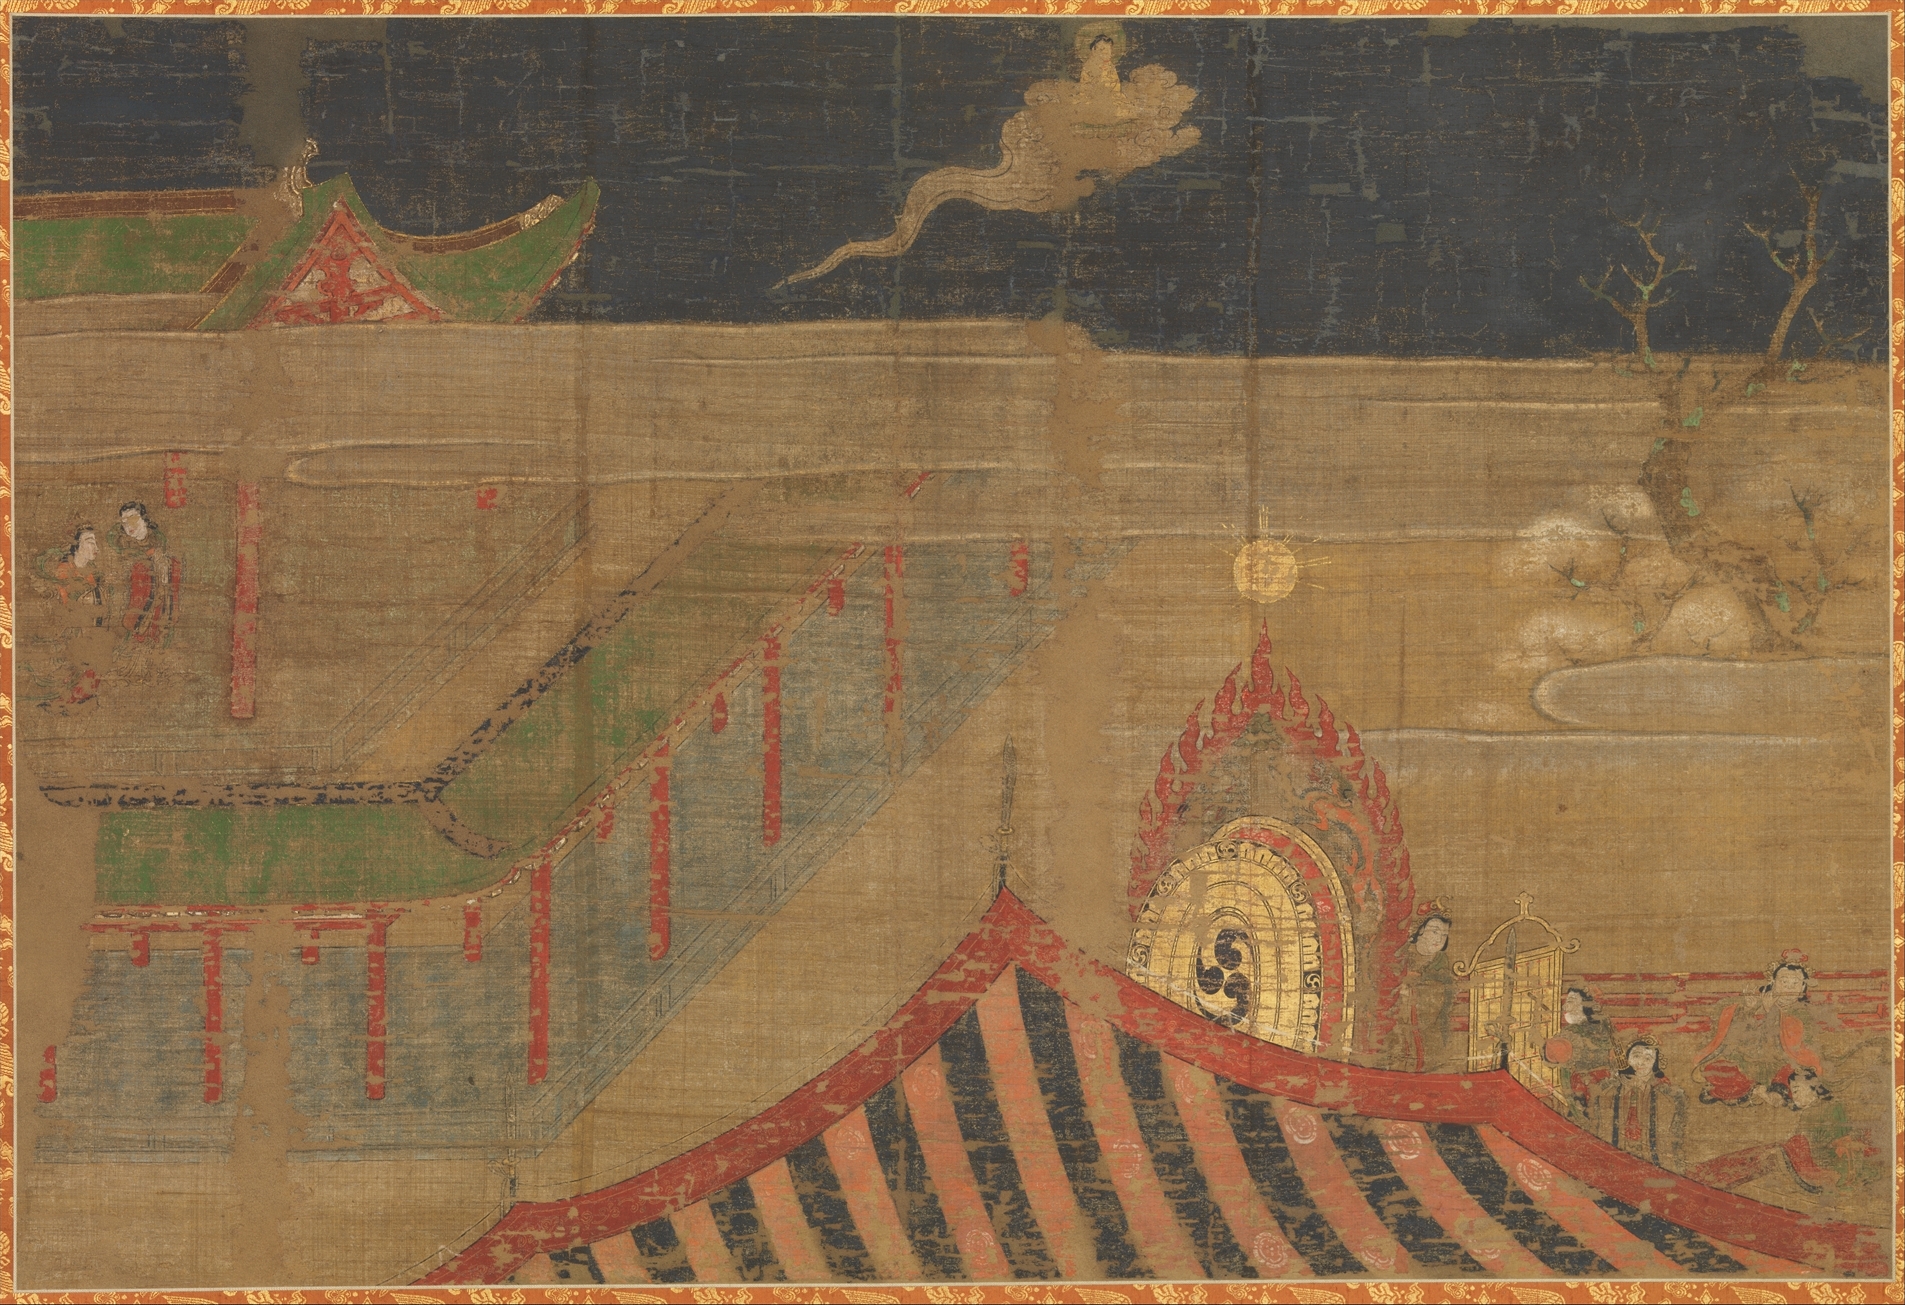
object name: hanging scroll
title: Scene from the Life of the Buddha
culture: japanese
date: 1401-1433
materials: gold, ink, panel, silk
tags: palaces,men,women,buddha